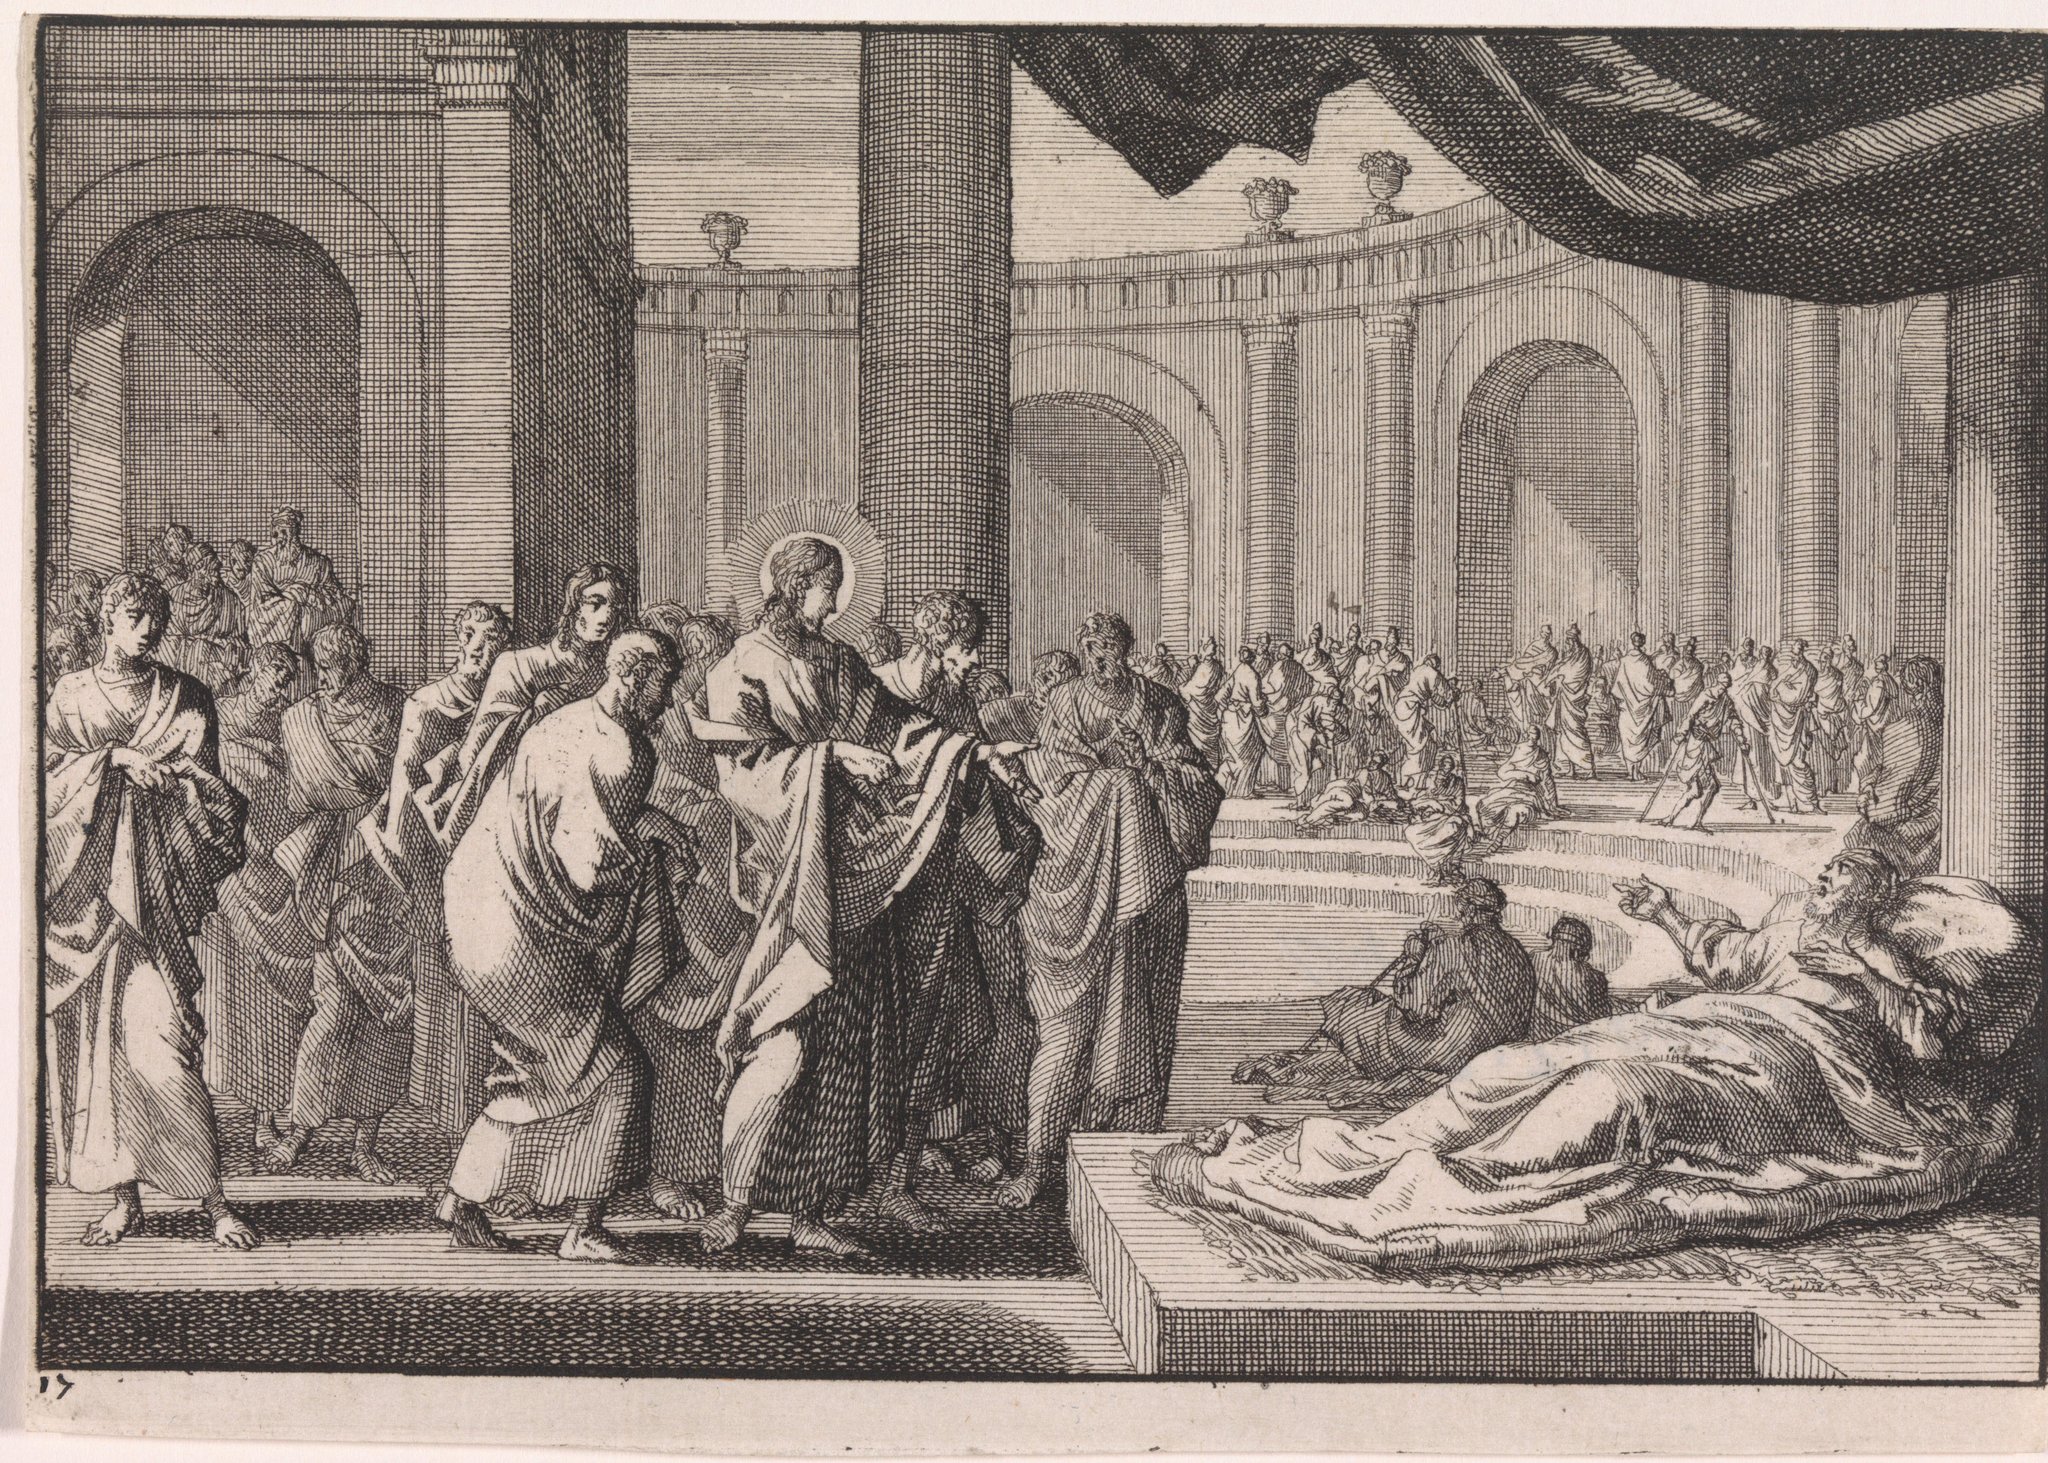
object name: print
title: Genezing van de man bij het bad van Betesda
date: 1703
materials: paper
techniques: etching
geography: amsterdam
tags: christ says to a paralytic man: 'rise, take up your pallet (bed)', john the baptist in prison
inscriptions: collector's mark: Lugt 2228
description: Proefdruk van een boekillustratie voor David Martin. Historie des Ouden en Nieuwen Testaments. Amsterdam, Pieter Mortier, 1703. Deel II. De boekillustraties voor de Mortierbijbel hebben verschillende staten en kopieën, waarbij de chronologische volgorde moeilijk te achterhalen valt. Als boekillustraties werden ze bovendien herhaaldelijk opnieuw gebruikt voor andere boekwerken.